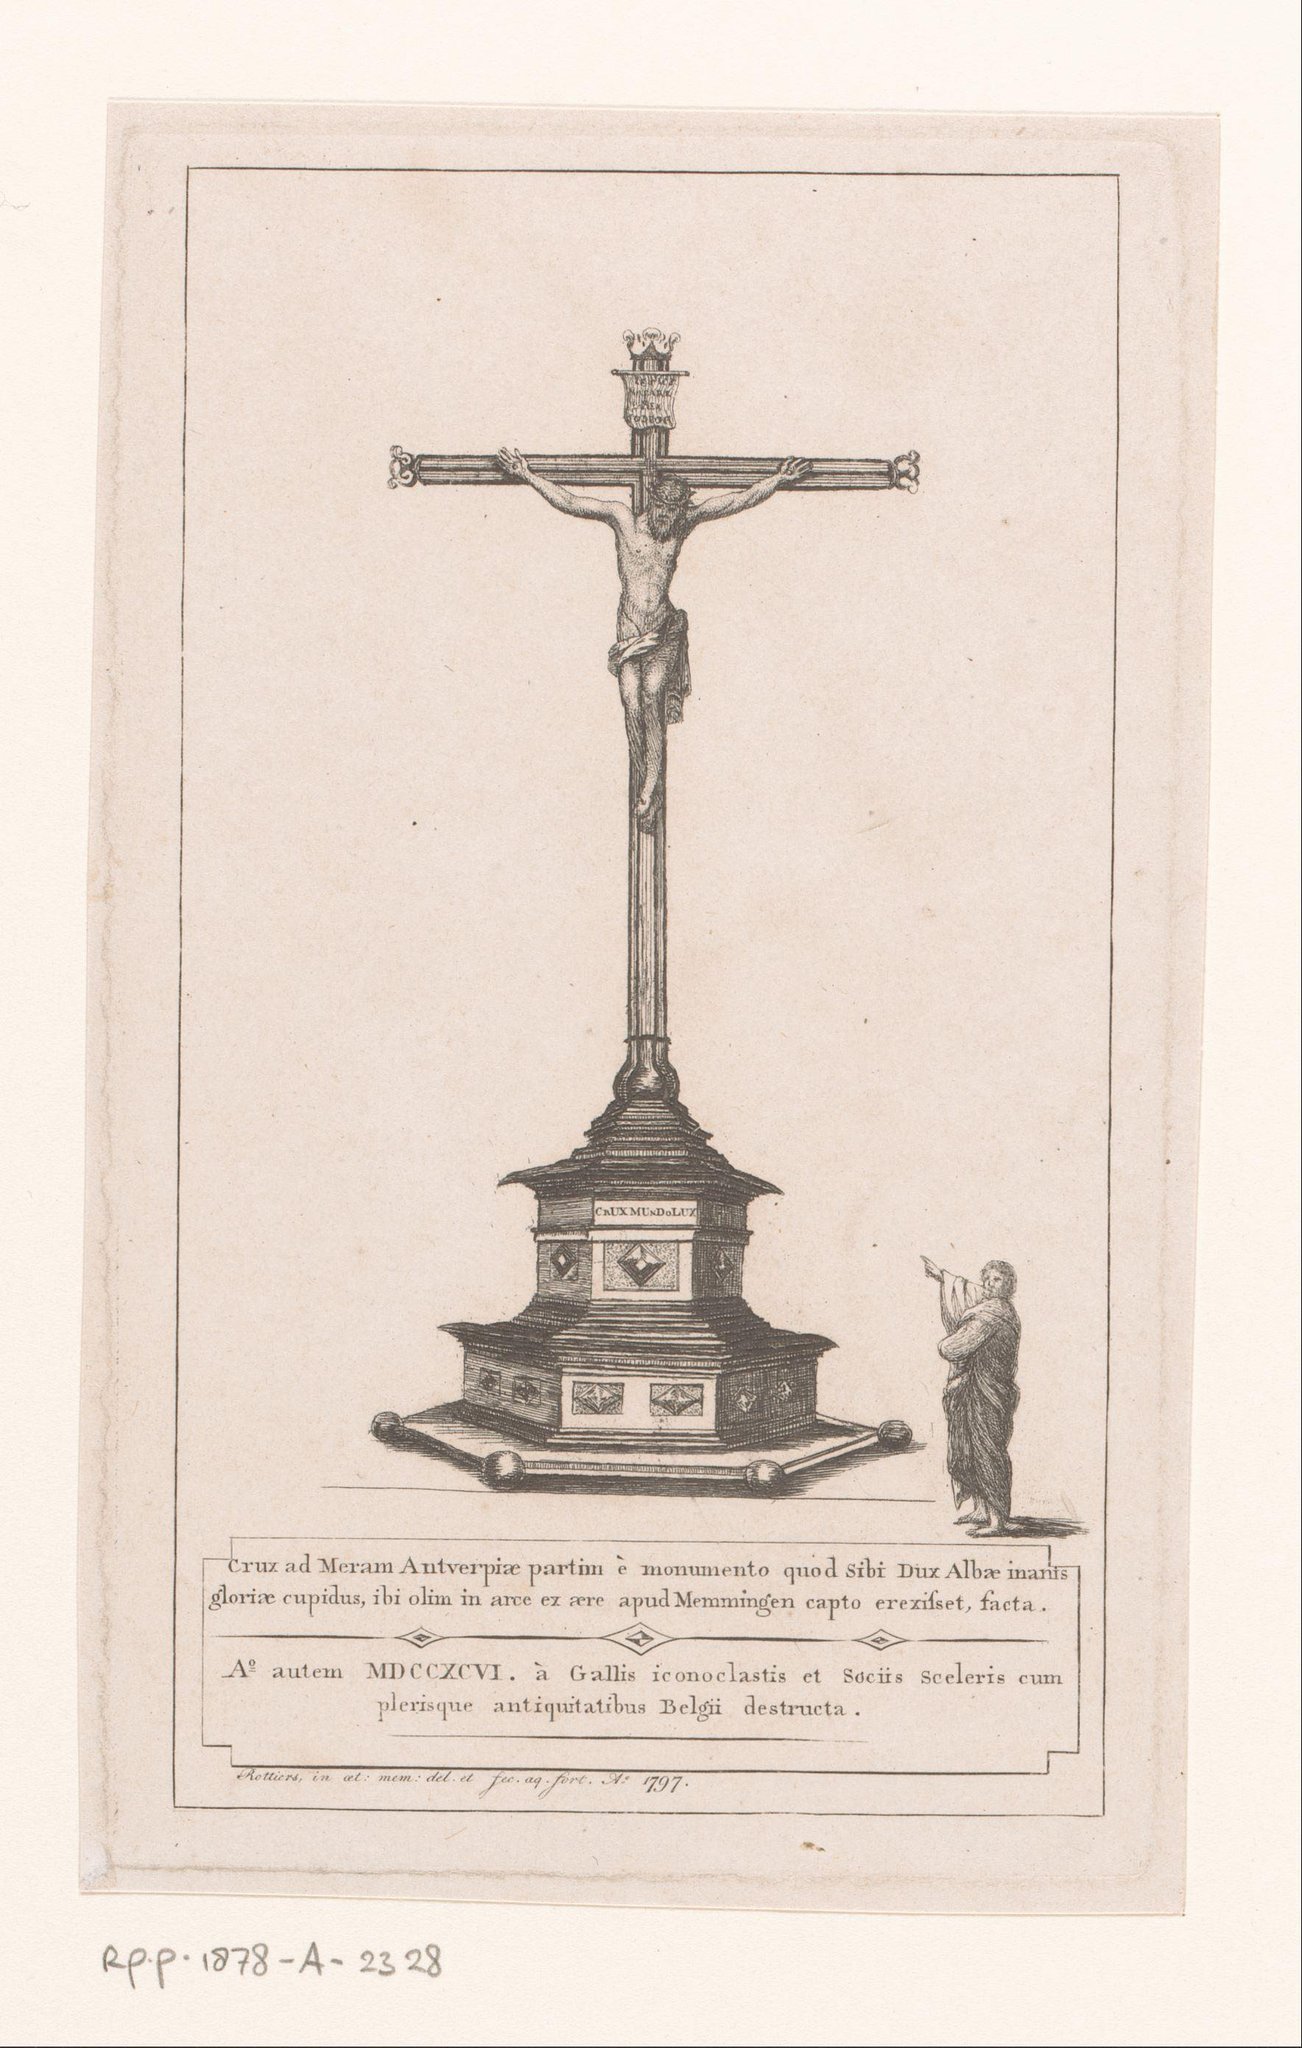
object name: print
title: Man wijzend naar een groot crucifix beeld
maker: bernard eugène antoine rottiers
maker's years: 1771-1857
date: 1797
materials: paper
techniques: etching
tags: crucifix ~ personal devotion, piece of sculpture, reproduction of a piece of sculpture, index finger forwards, pointing, indicating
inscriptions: collector's mark: Lugt 2228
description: De crucifix is een afbeelding van een kruisbeeld op de Meir te Antwerpen dat in latere tijd is weggehaald.